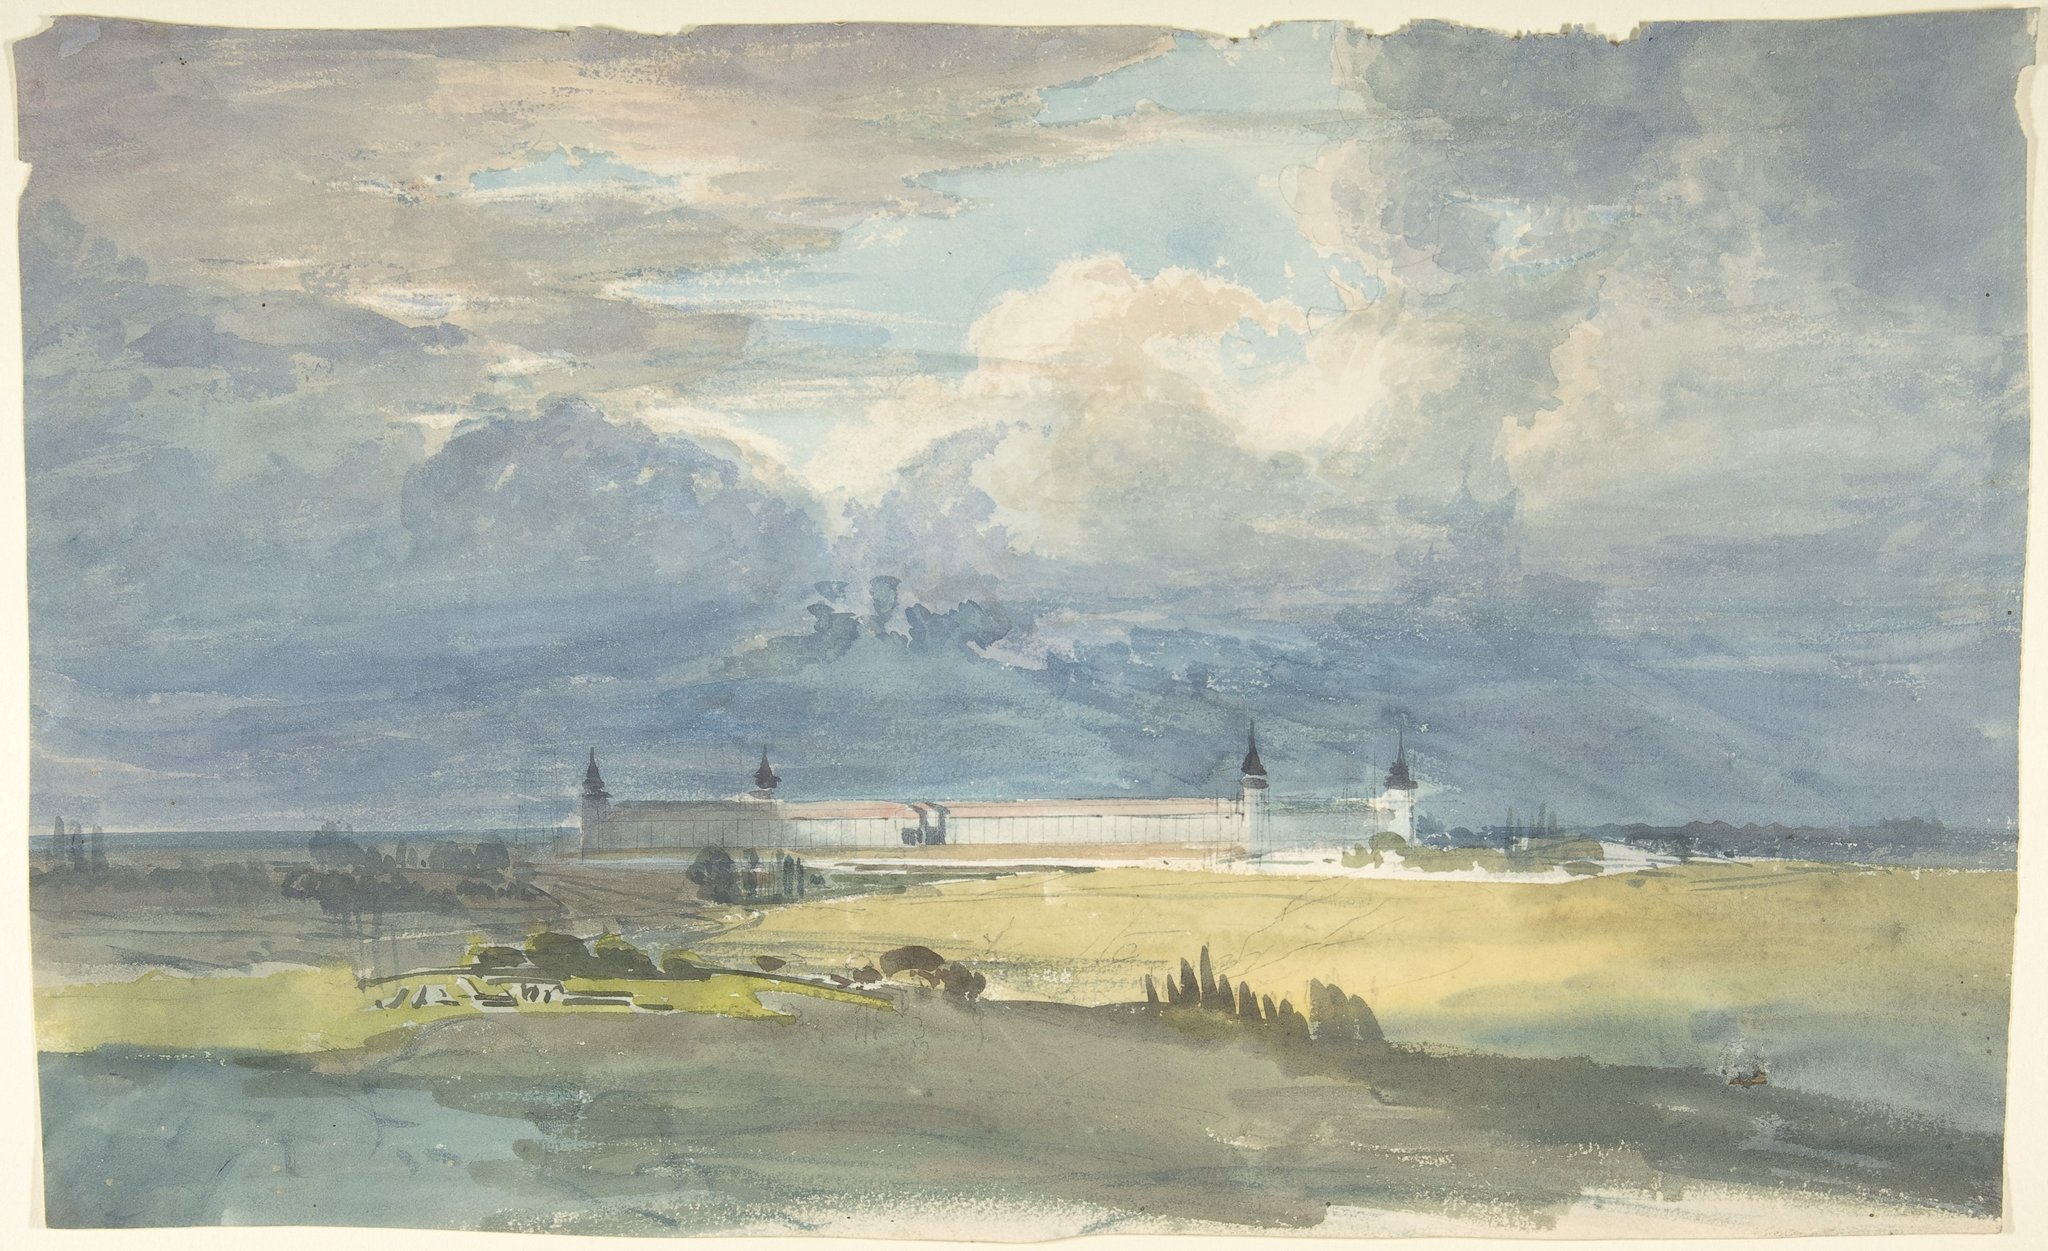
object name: drawing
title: Landscape with a Large Building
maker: franz von hauslab the younger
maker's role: artist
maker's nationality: austrian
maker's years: 1798-1883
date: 1818-1883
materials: graphite, watercolor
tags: buildings,landscapes